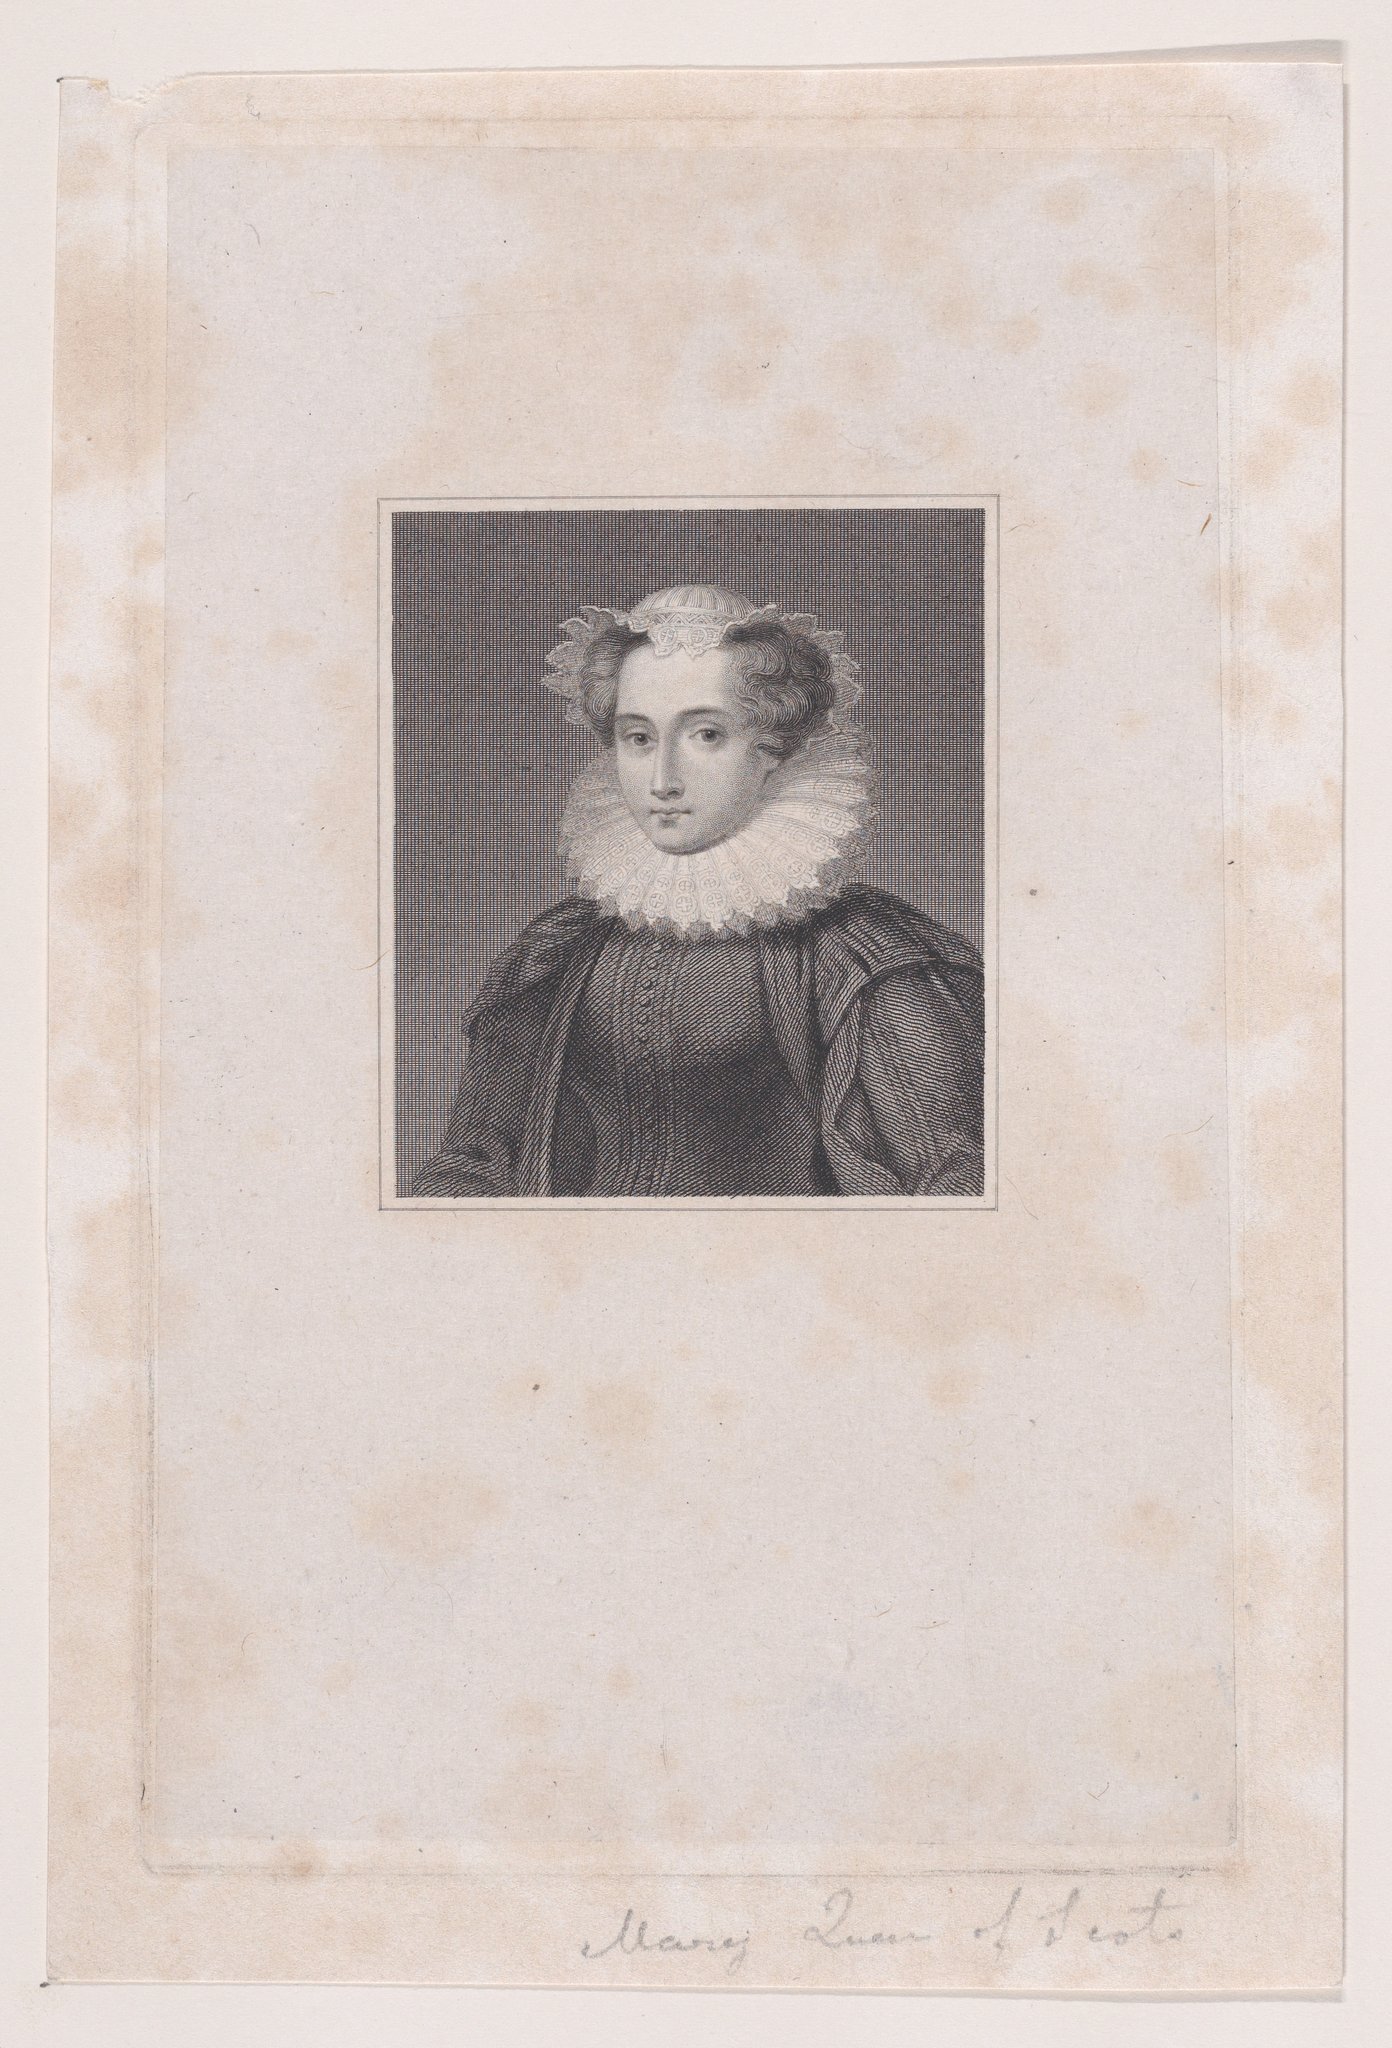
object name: print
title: Mary, Queen of Scots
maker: robert cooper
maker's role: artist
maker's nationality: british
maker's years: -1828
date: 1801-1833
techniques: engraving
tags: queens,portraits,women,mary queen of scots